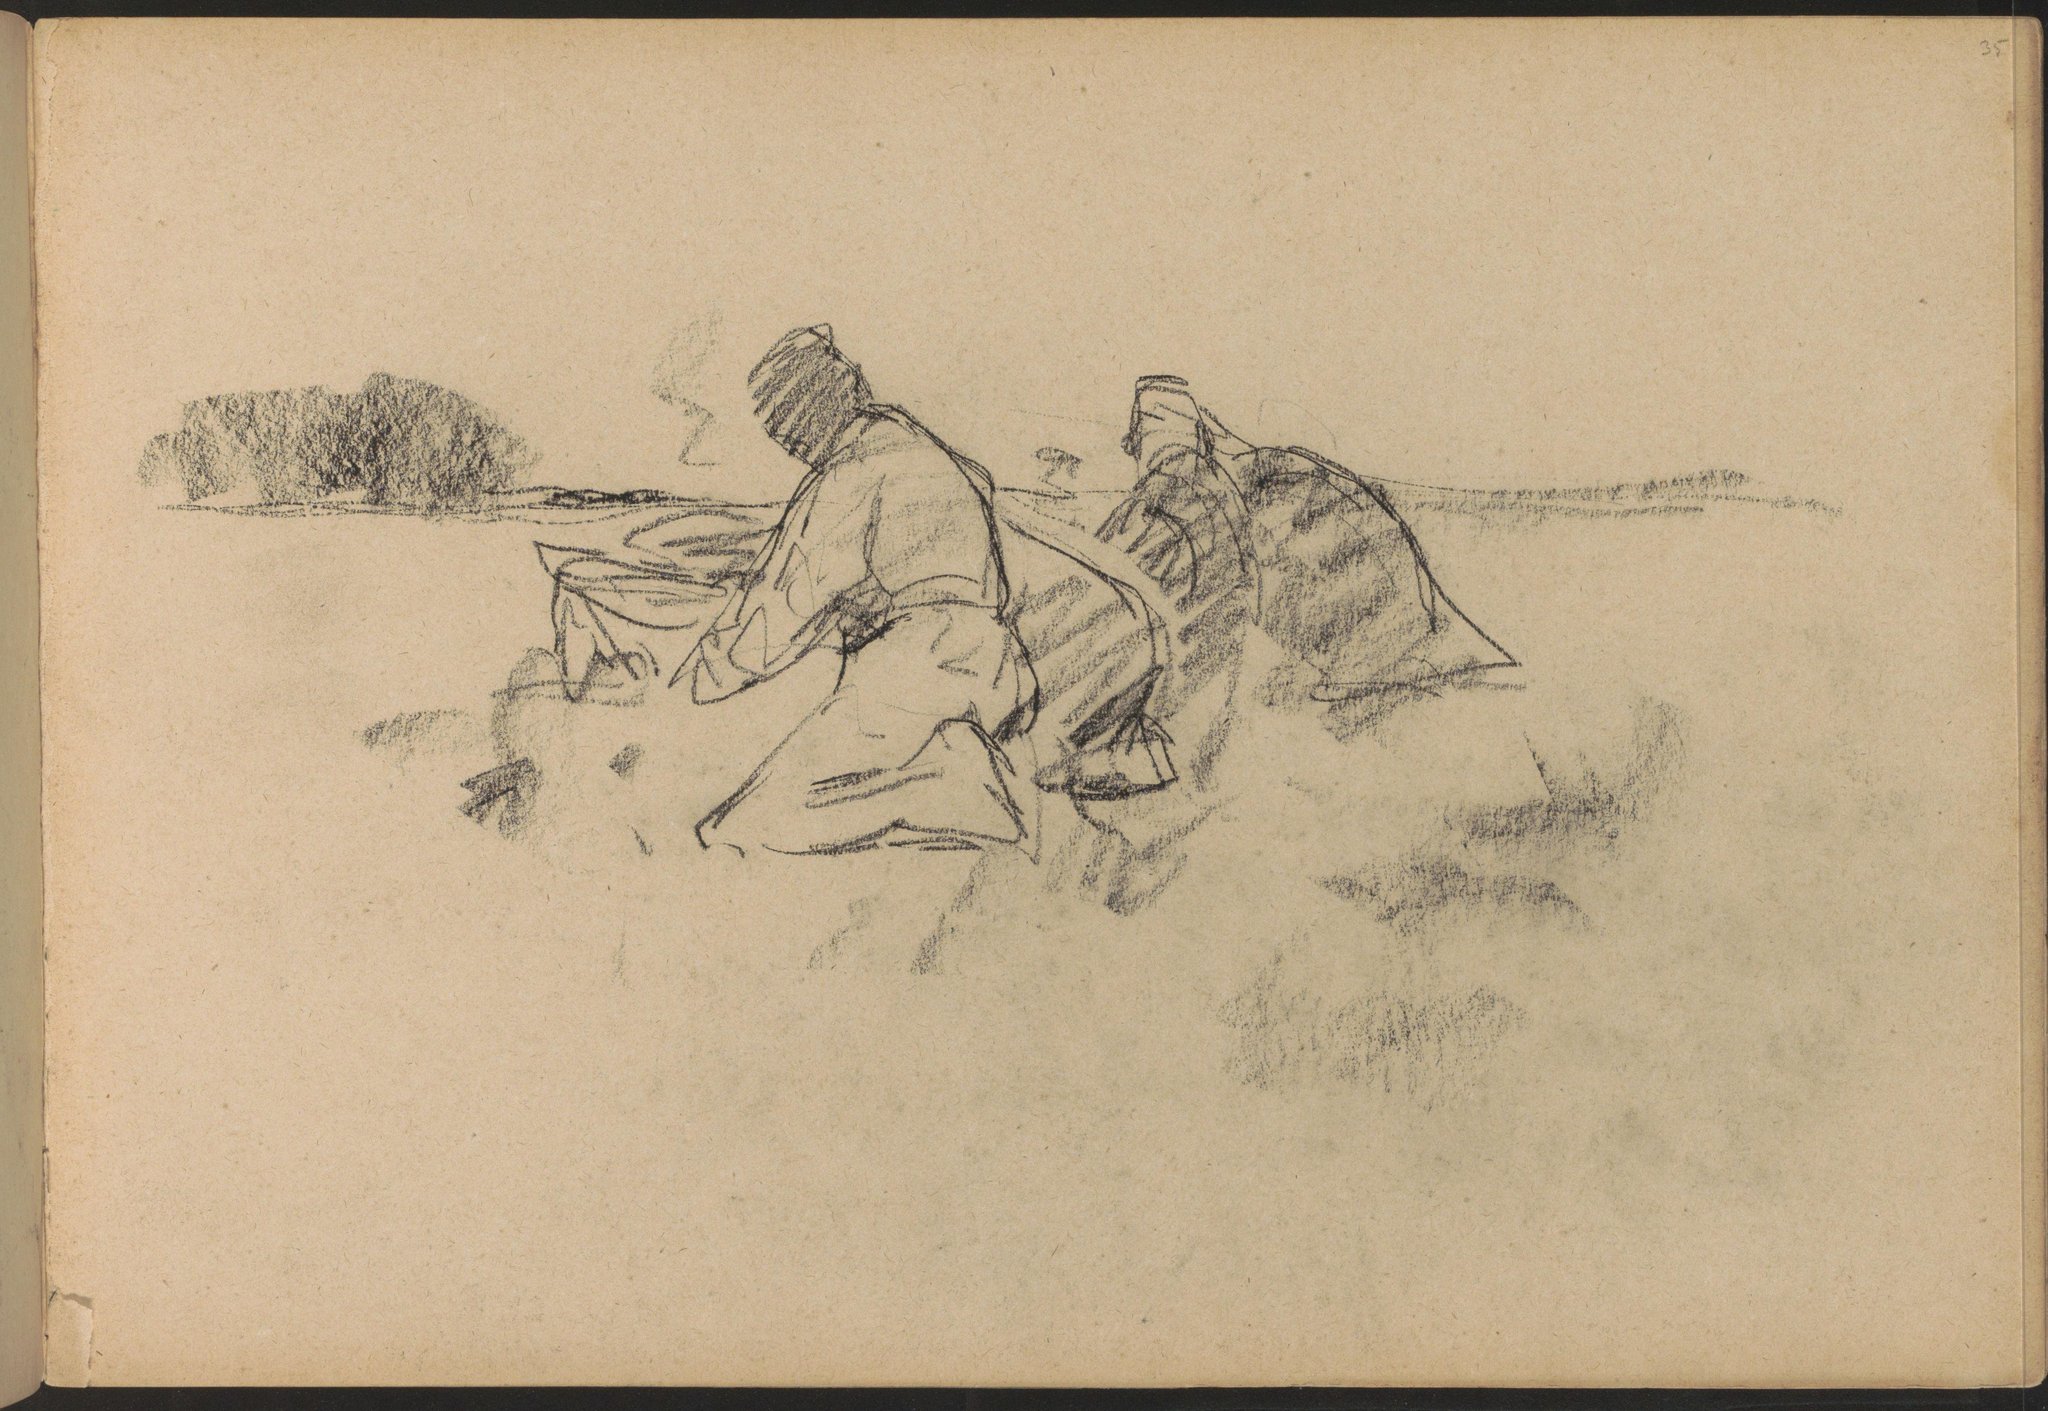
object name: sketchbook leaf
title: Knielende figuren aan het werk op het land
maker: willem witsen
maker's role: draughtsman, painter, print maker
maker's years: 1860-1923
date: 1882-1884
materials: chalk, paper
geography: ewijkshoeve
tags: kneeling figure - aa - female human figure, reaping, picking, mowing ~ harvest, cultivated land (+ landscape with figures, staffage)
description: Ze rooien mogelijk. Pagina 35 uit een schetsboek met 19 bladen.